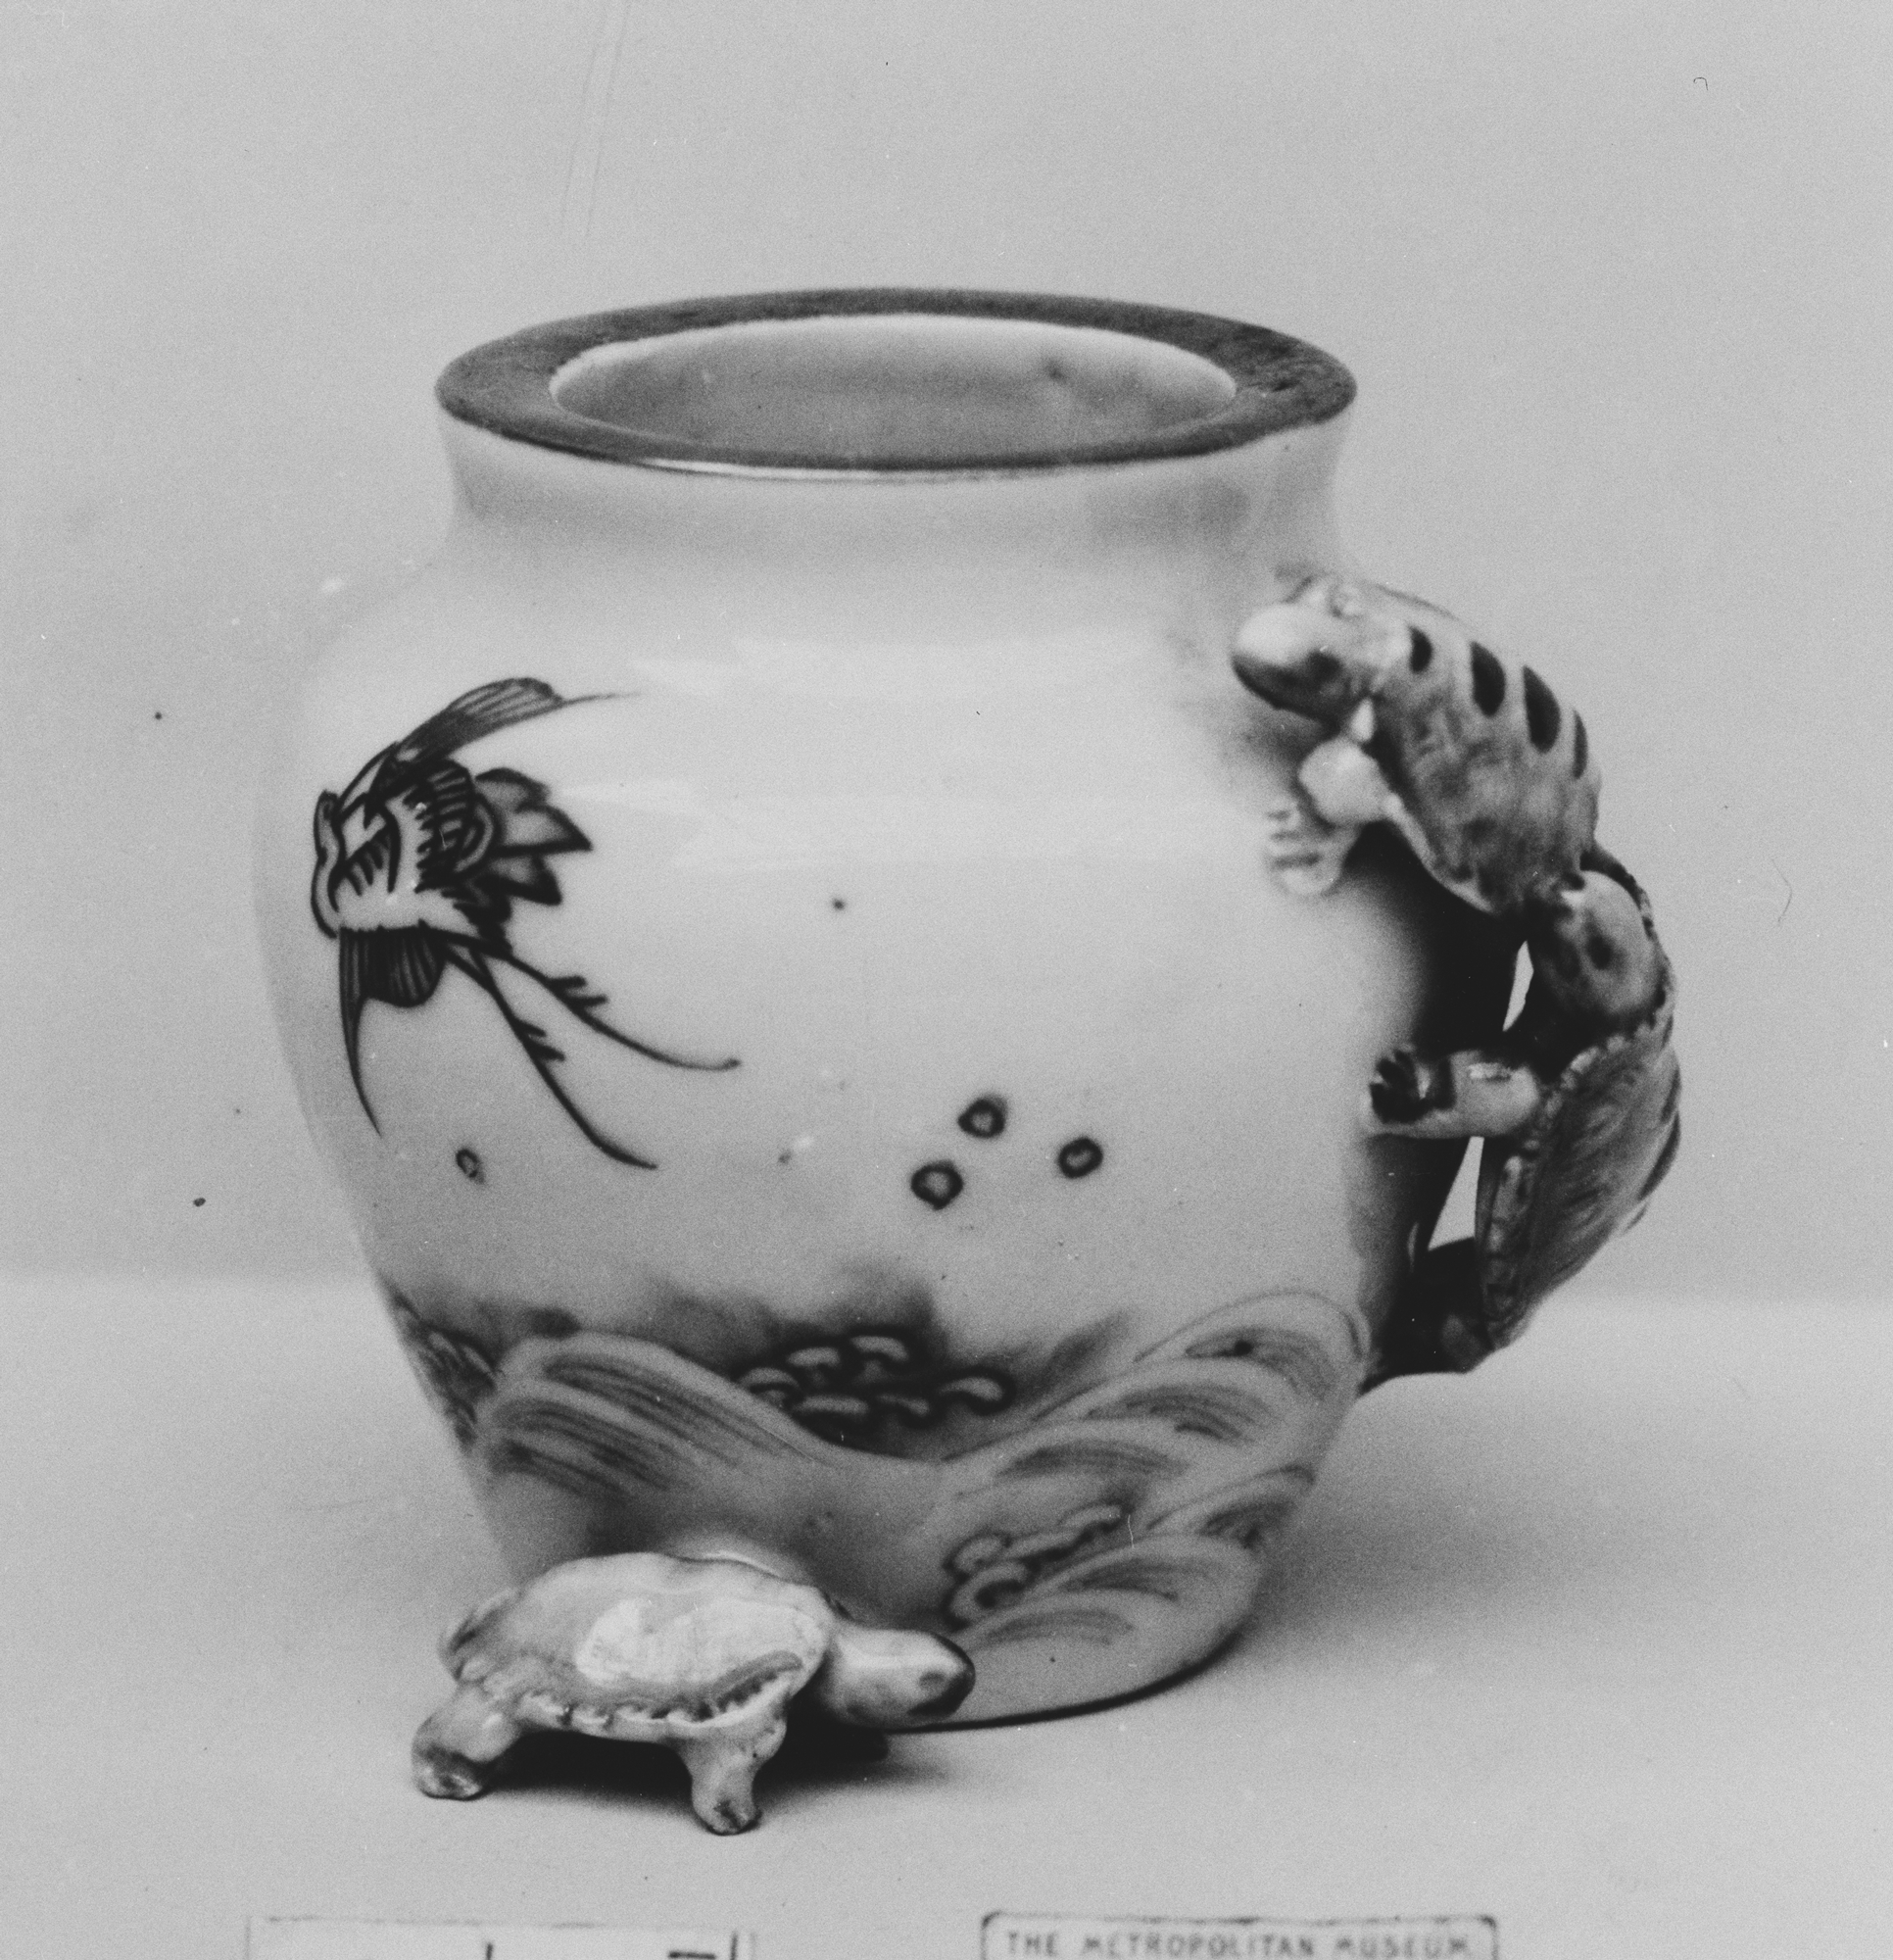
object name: vase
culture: japanese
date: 1870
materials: glaze, gold, porcelain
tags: turtles